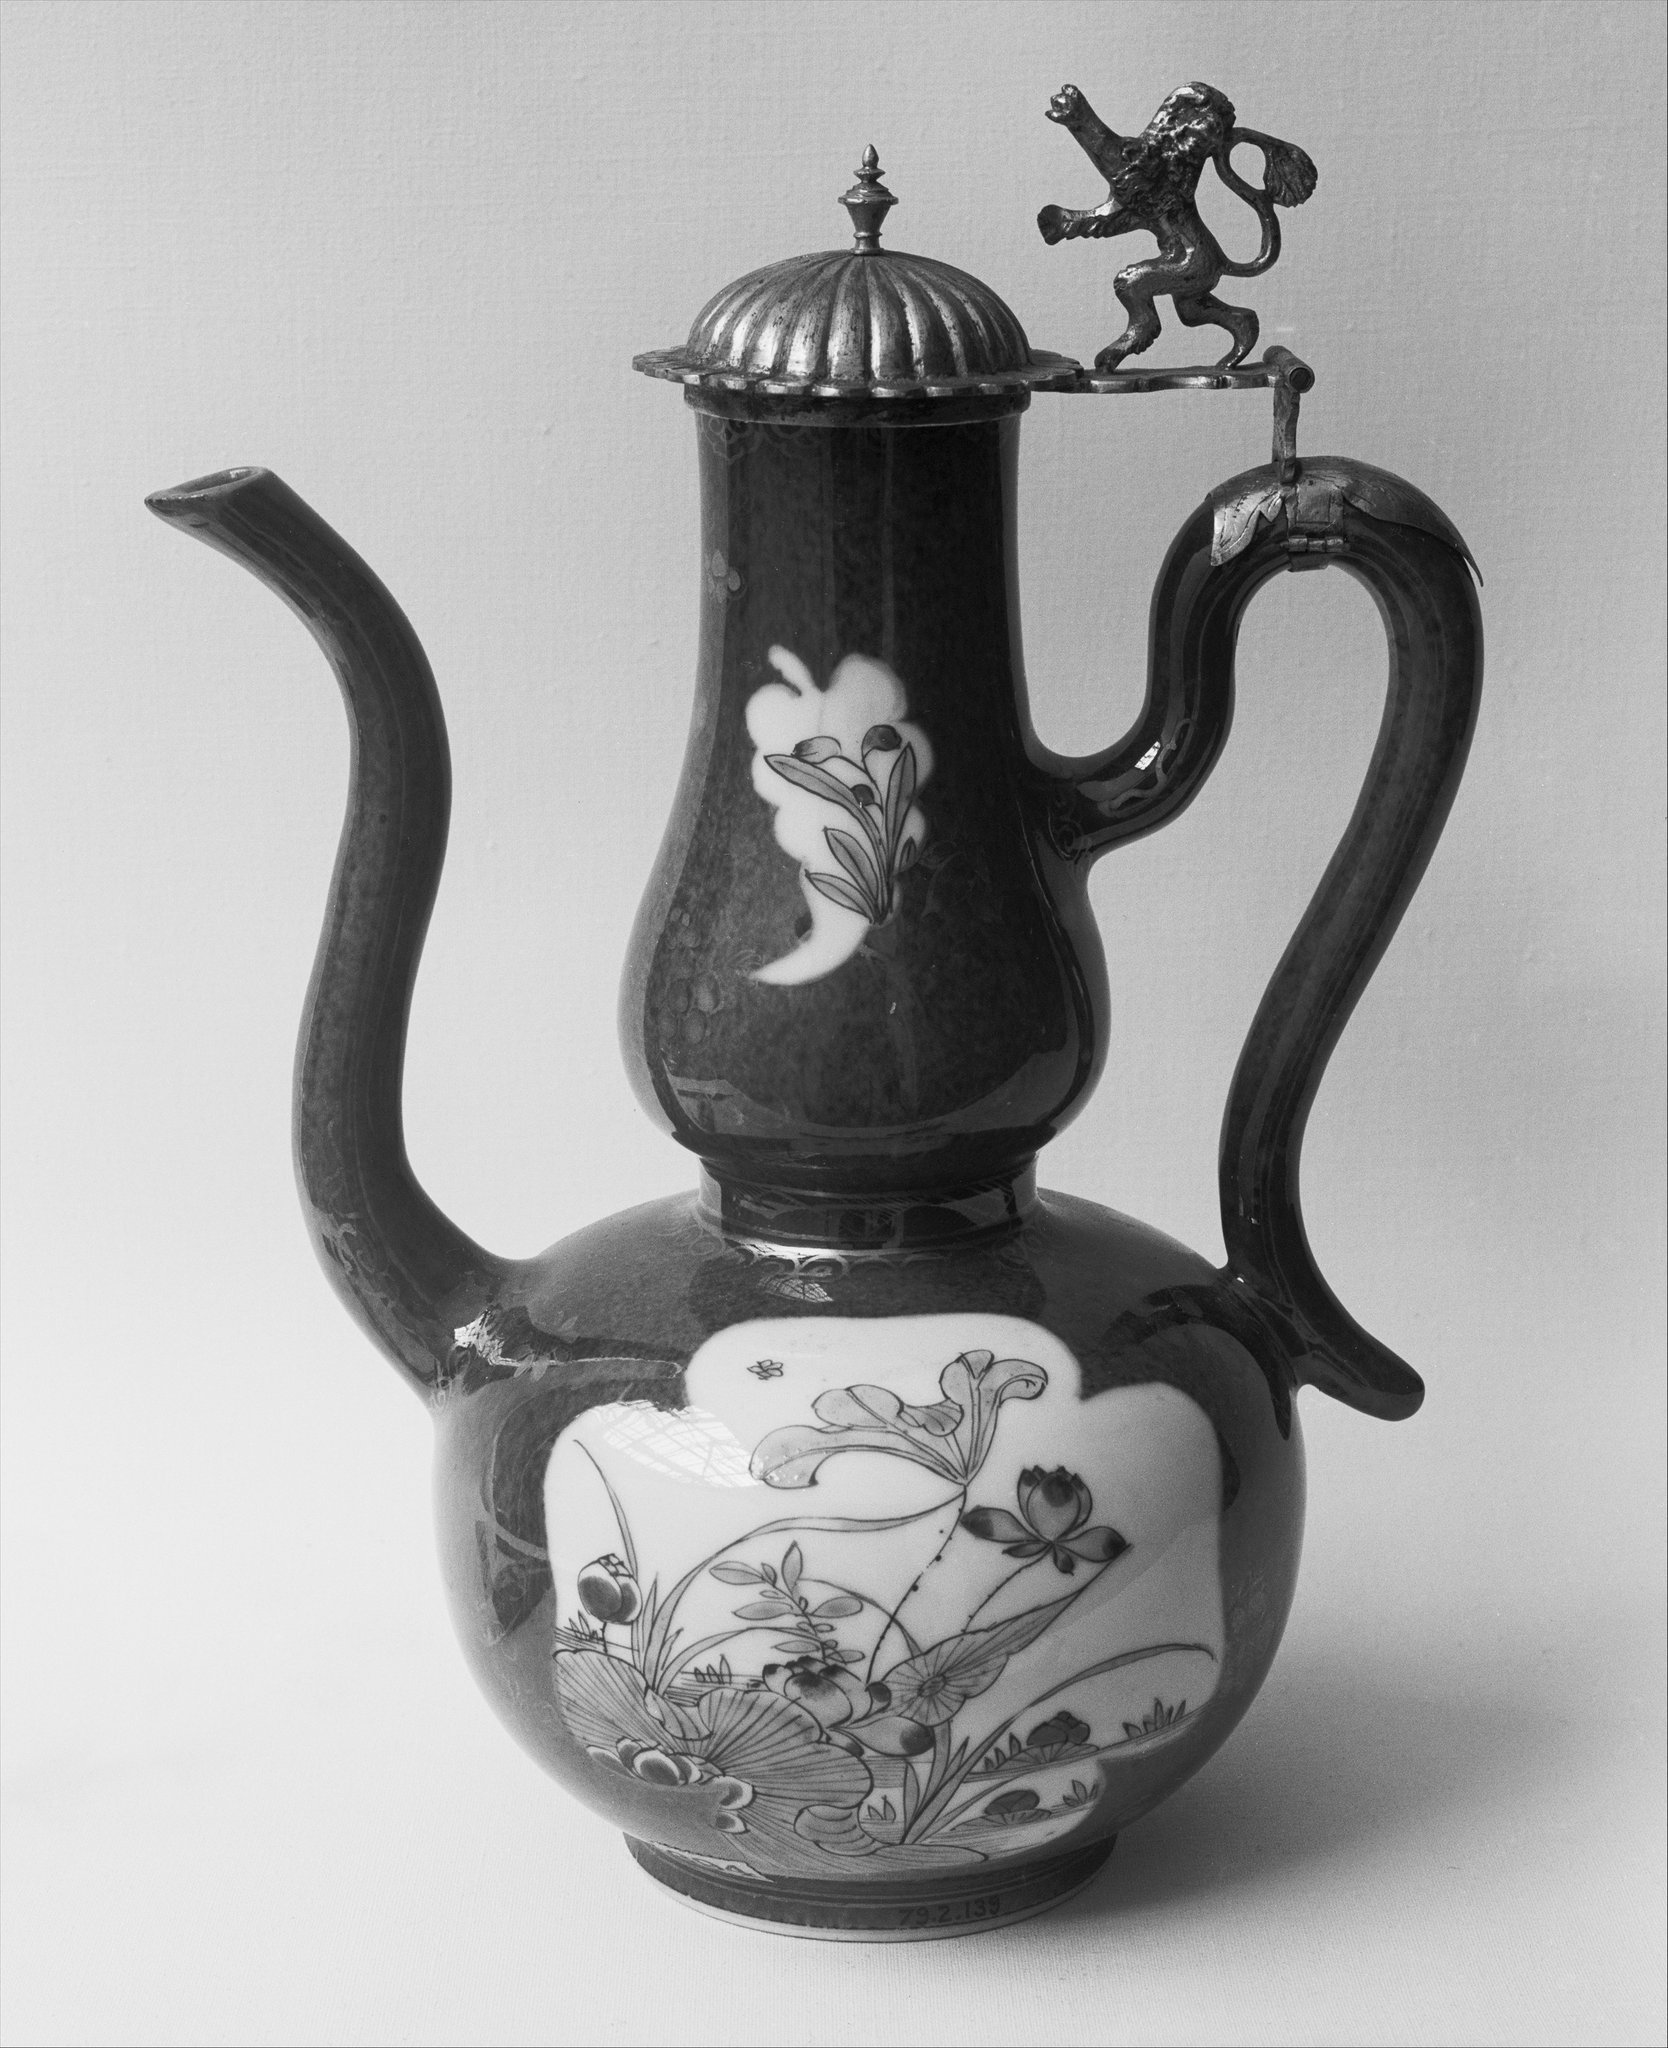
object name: ewer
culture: chinese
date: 1667-1733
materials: enamel, gilt bronze, glaze, porcelain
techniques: overglaze, painting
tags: animals,flowers